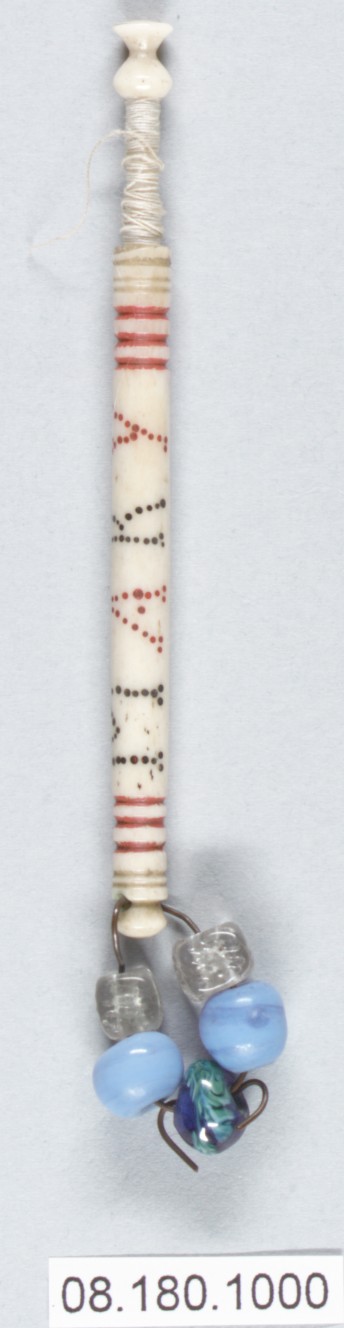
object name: bobbin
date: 1801-1900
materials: bone